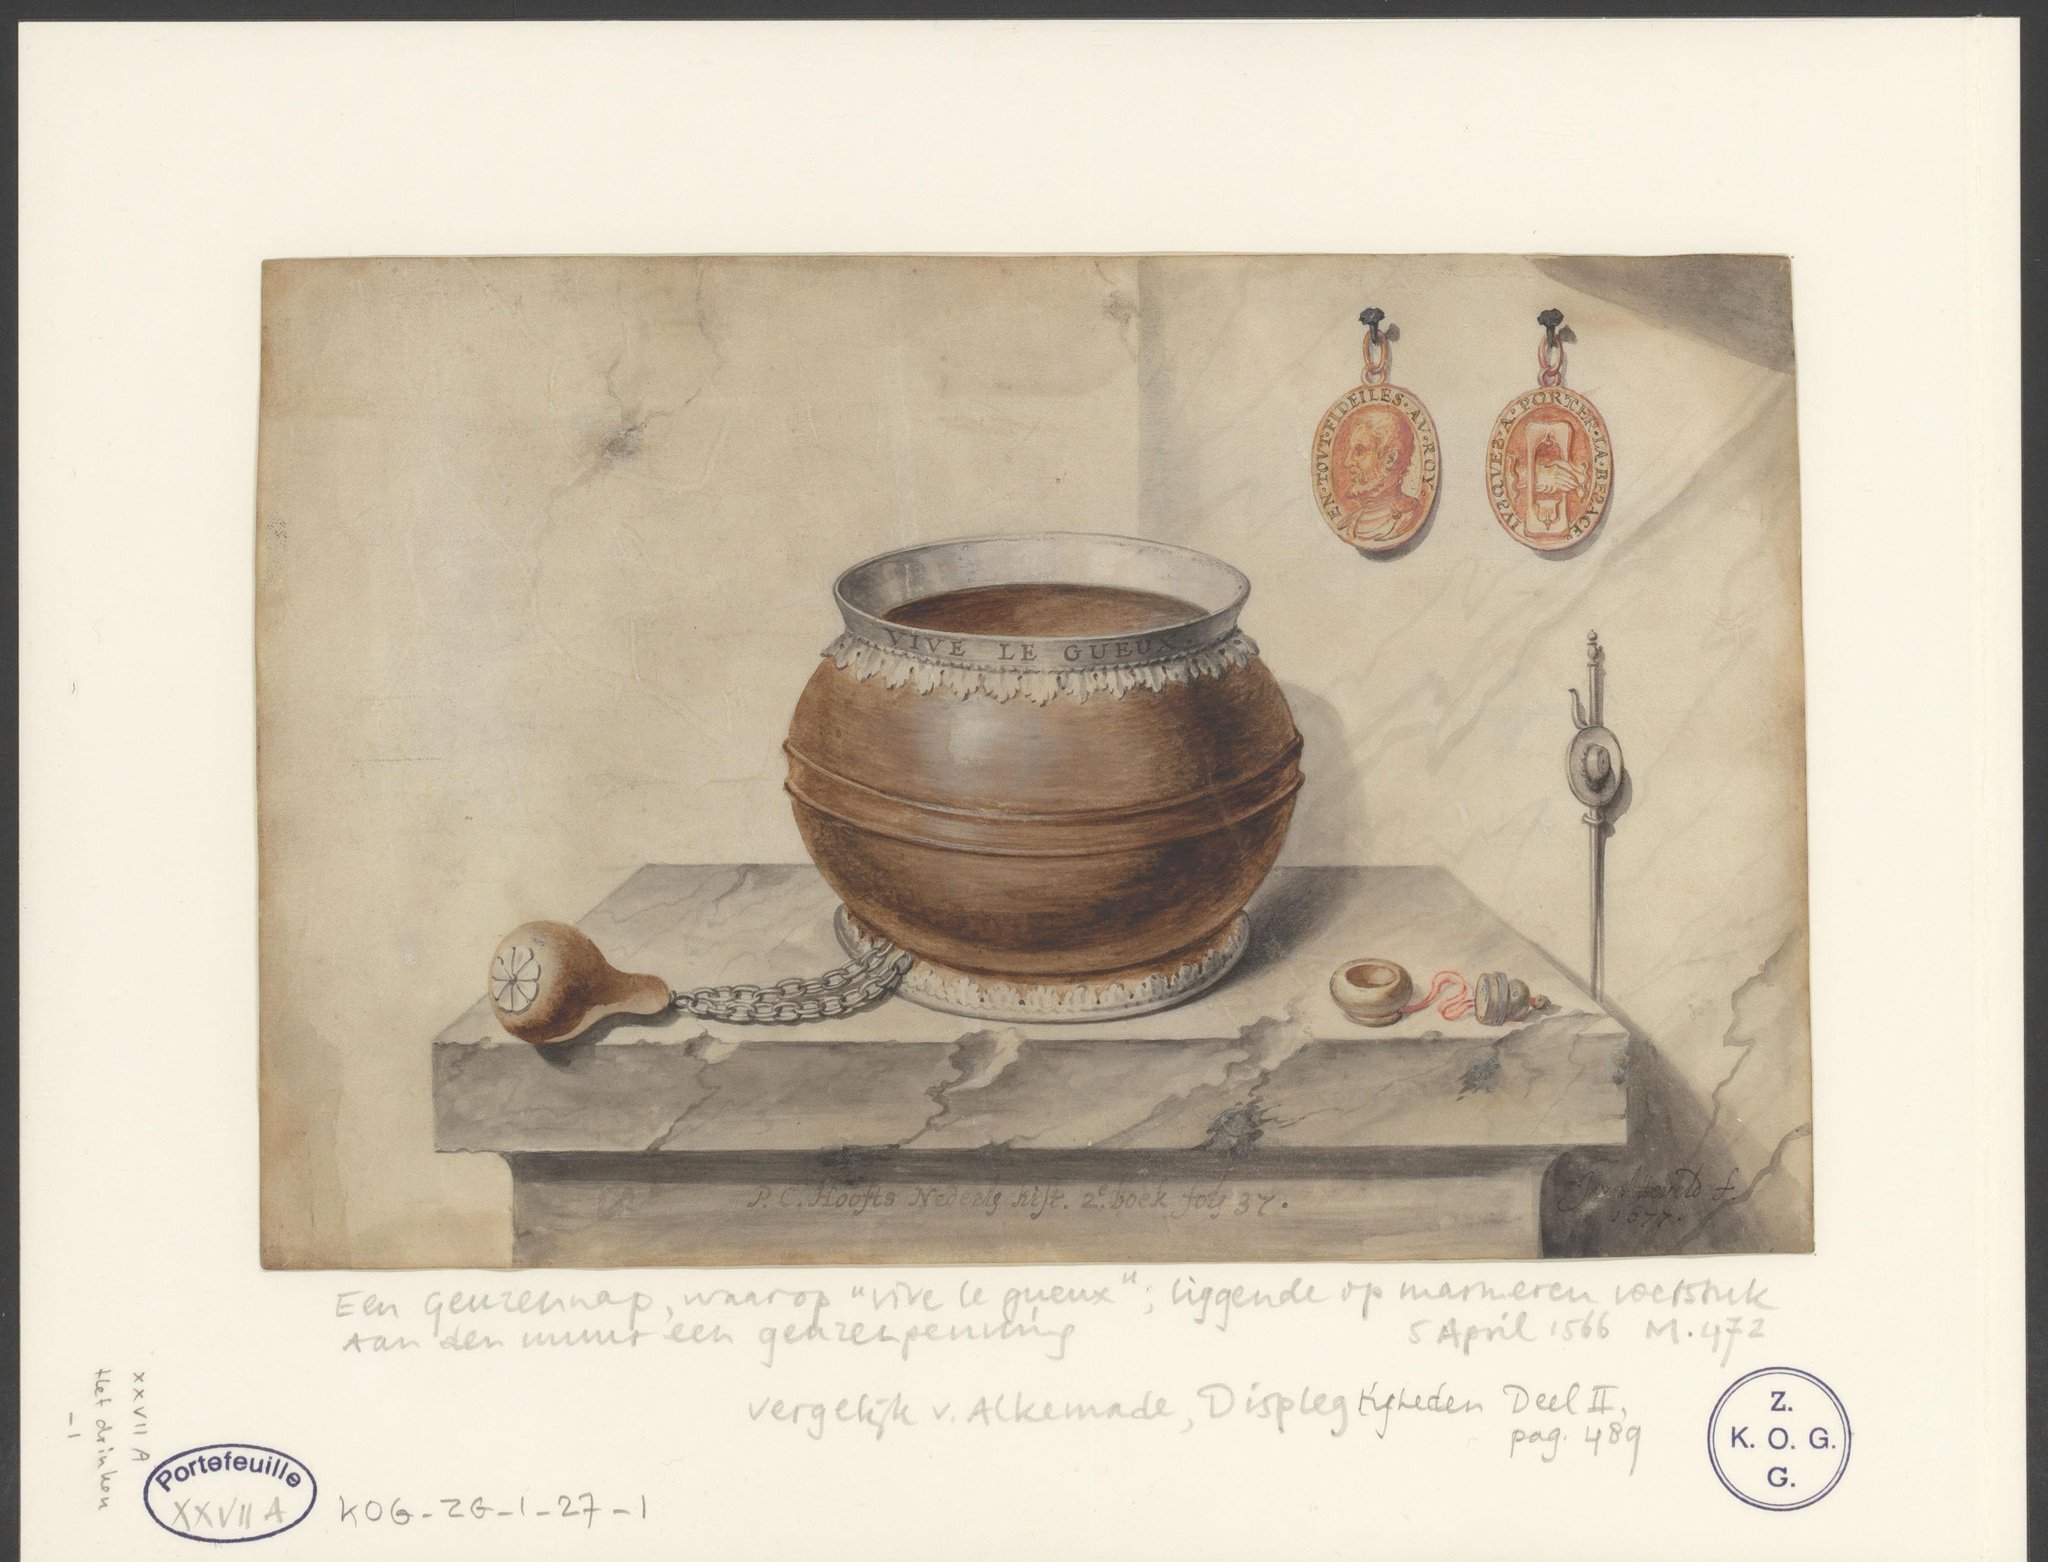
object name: drawing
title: Geuzennap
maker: justus van attevelt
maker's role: draughtsman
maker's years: 1621-1692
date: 1677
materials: ink, parchment, watercolor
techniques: brush, pen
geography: netherlands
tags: begging bowl, alcoholic drinks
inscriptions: collector's mark, collector's mark: Lugt 1641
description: Geuzennap met zilveren beslag uit 1566 waarop de leus 'vive le gueux', staande op een marmeren voetstuk waarop een referentie naar P.C. Hoofts Nederlandsche Historien 2e boek fol. 37. Op het stenen blad ligt ook een kleinere bedelnap. Aan de muur twee geuzenpenningen en een speld met een hoed. Onderwerpsrubrieken binnen de Atlas Zeden en Gewoonten: Genotmiddelen; Het drinken.